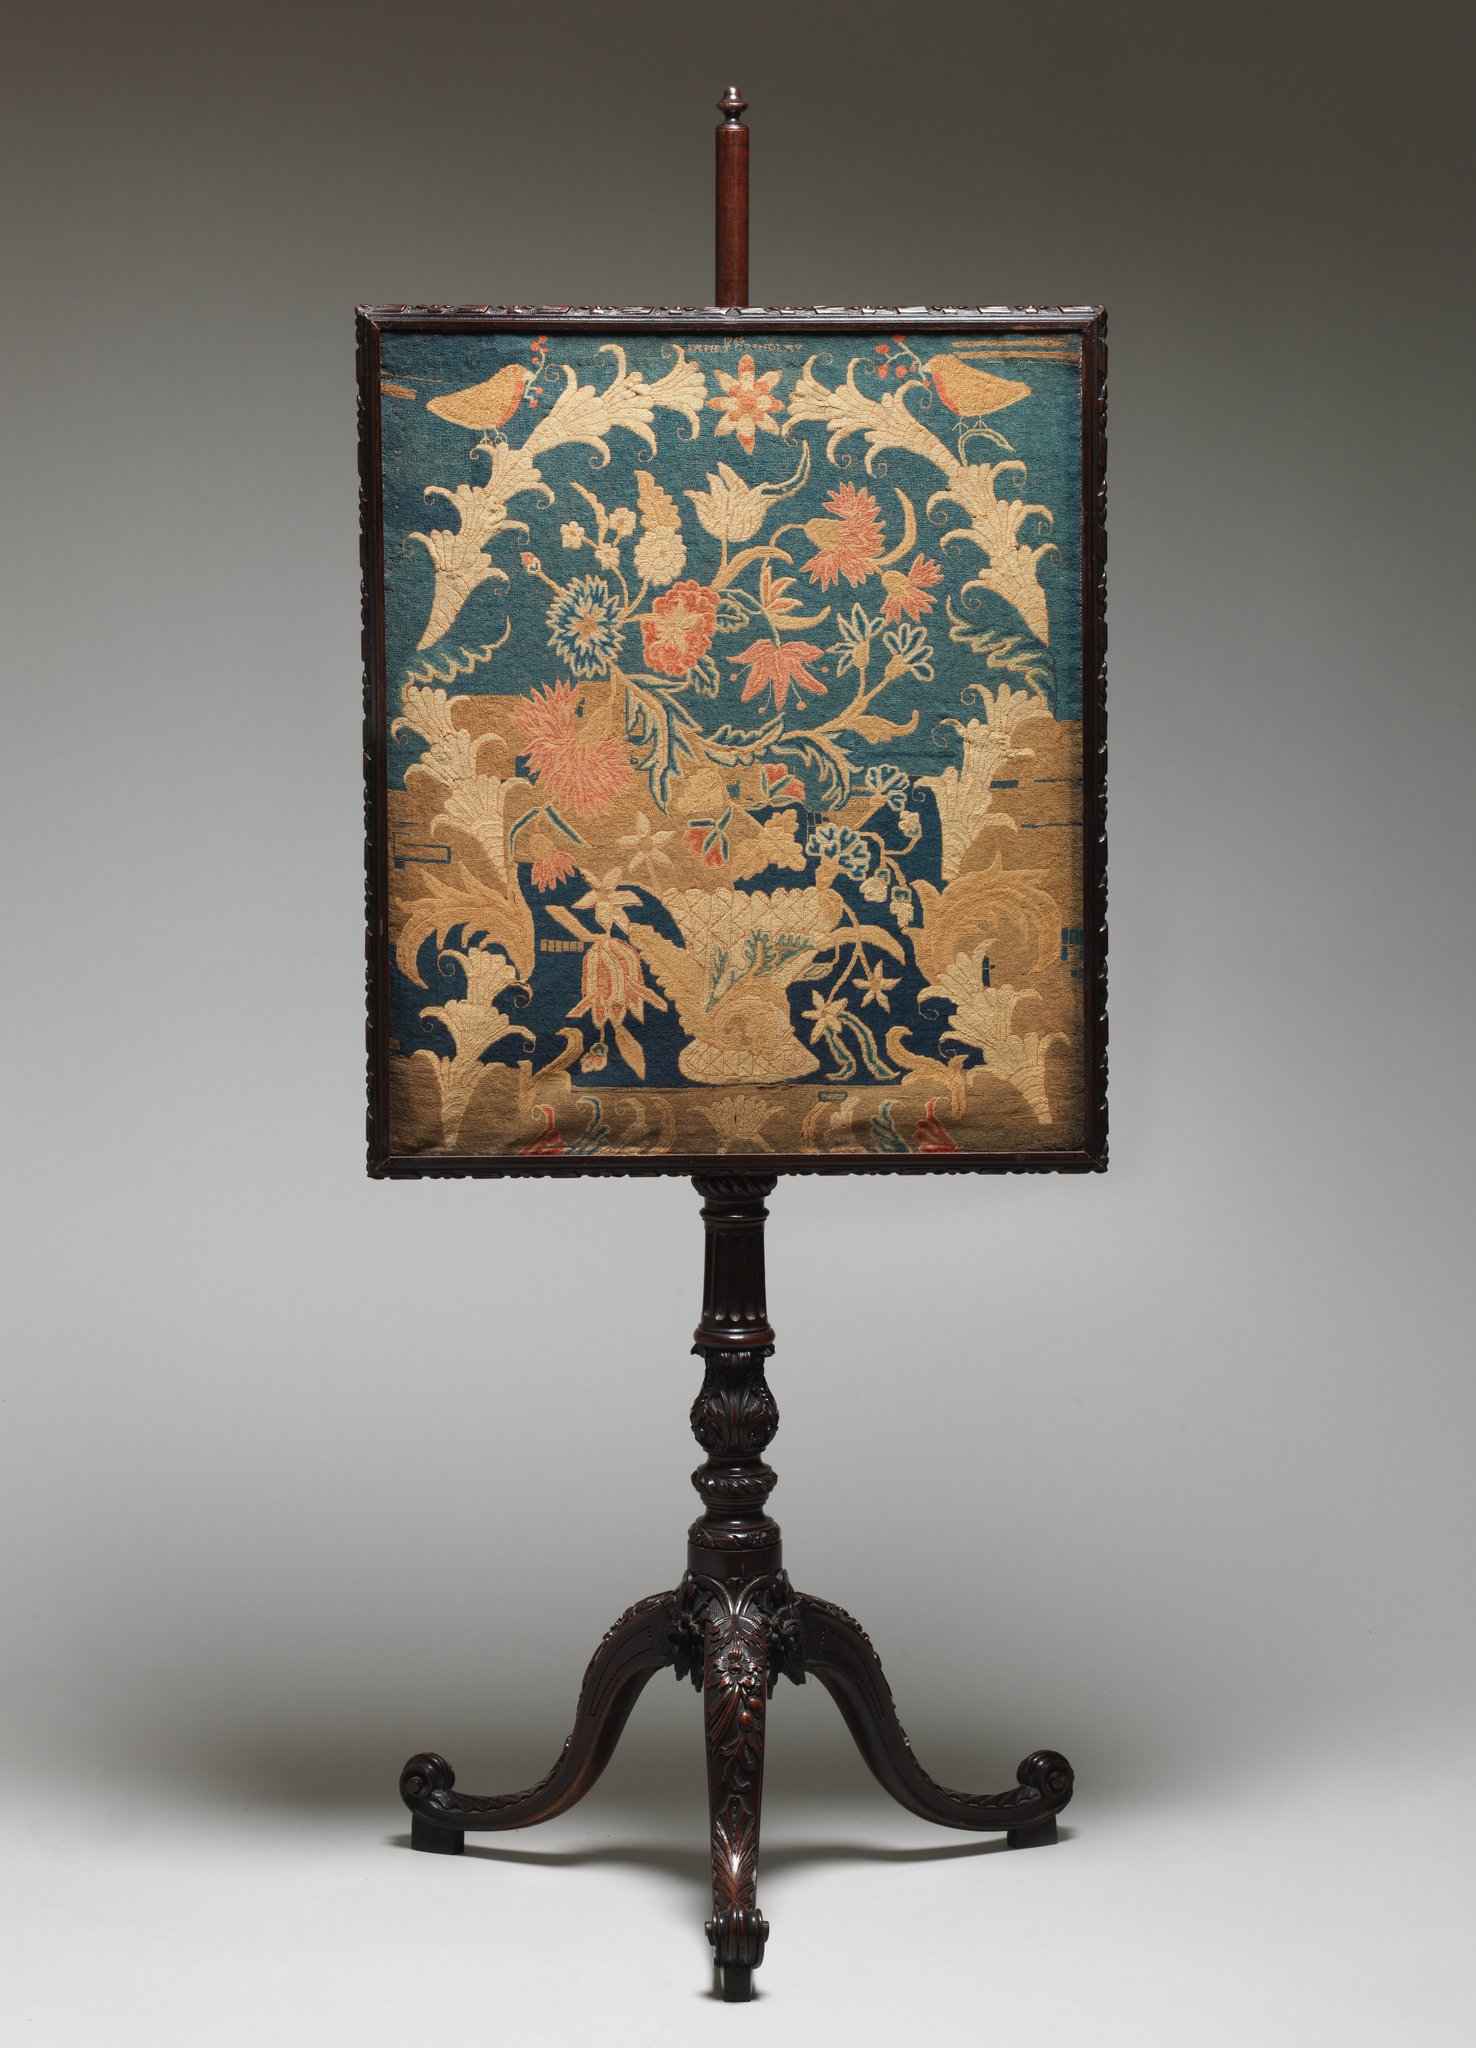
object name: pole screen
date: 1765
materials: wood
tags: birds,flowers